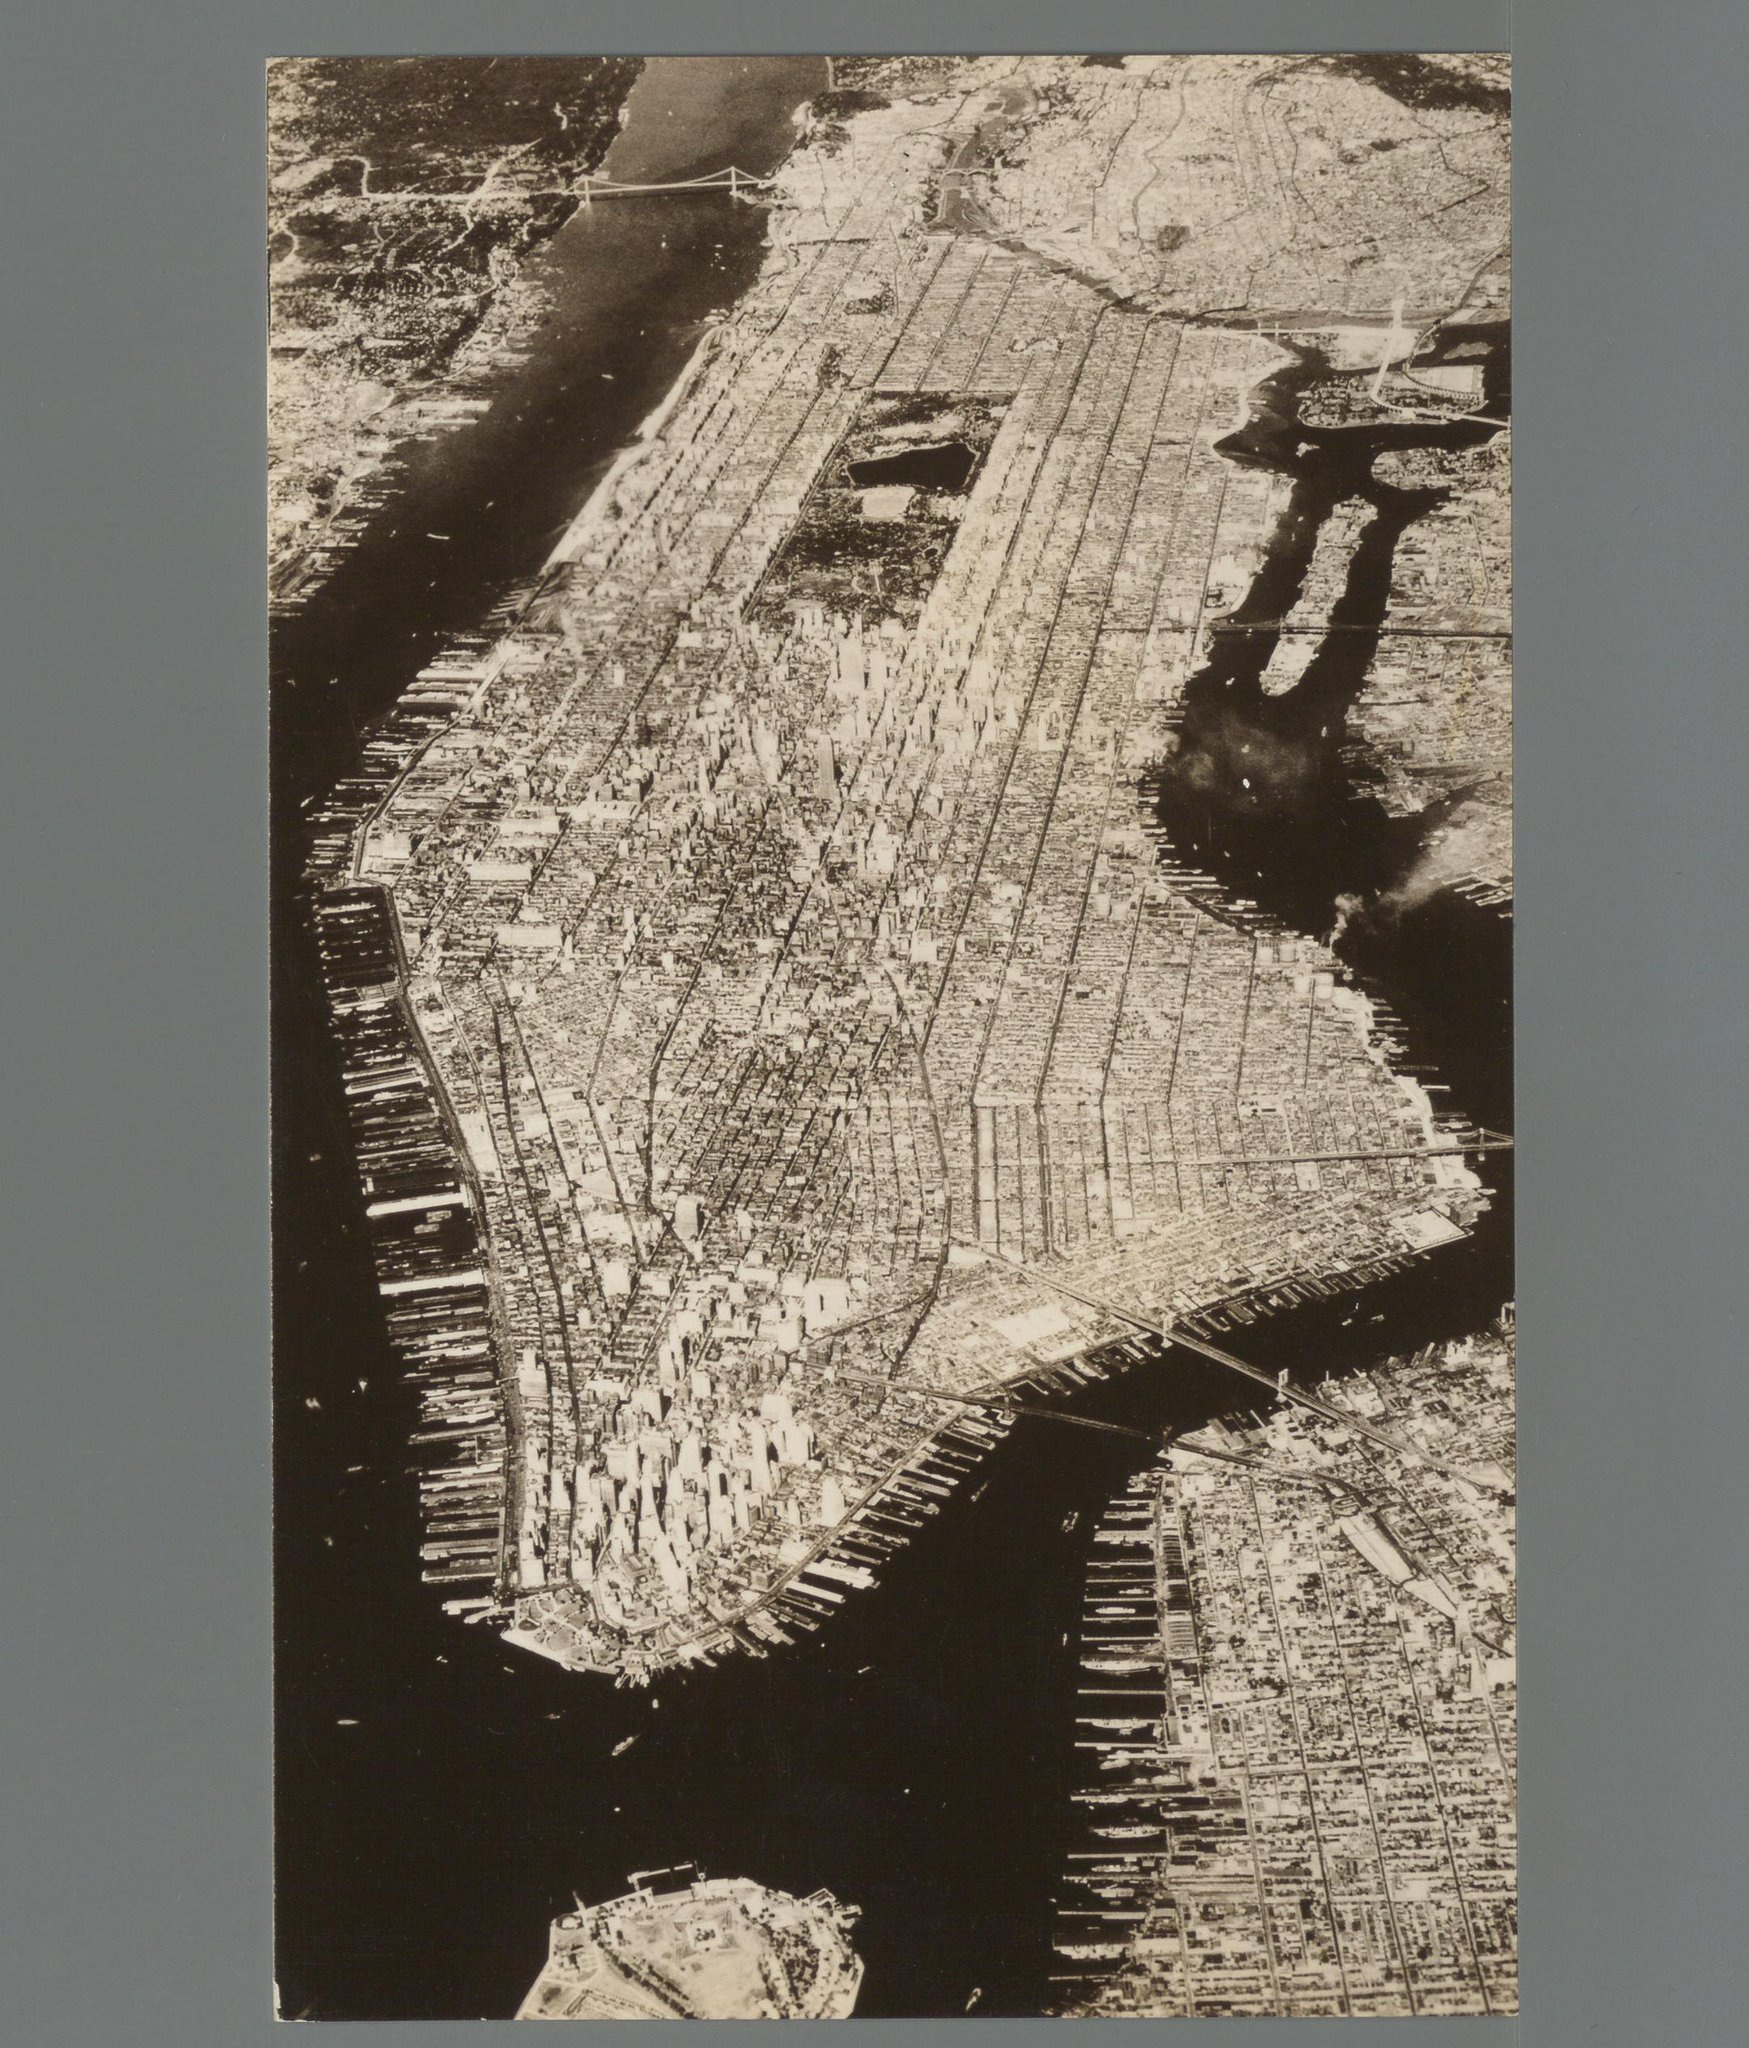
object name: ansichtkaart, prentbriefkaart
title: An airplane view of Manhattan Island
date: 1930-1950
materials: photographic support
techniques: photography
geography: new york city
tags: prospect of city, town panorama, silhouette of city, manhattan